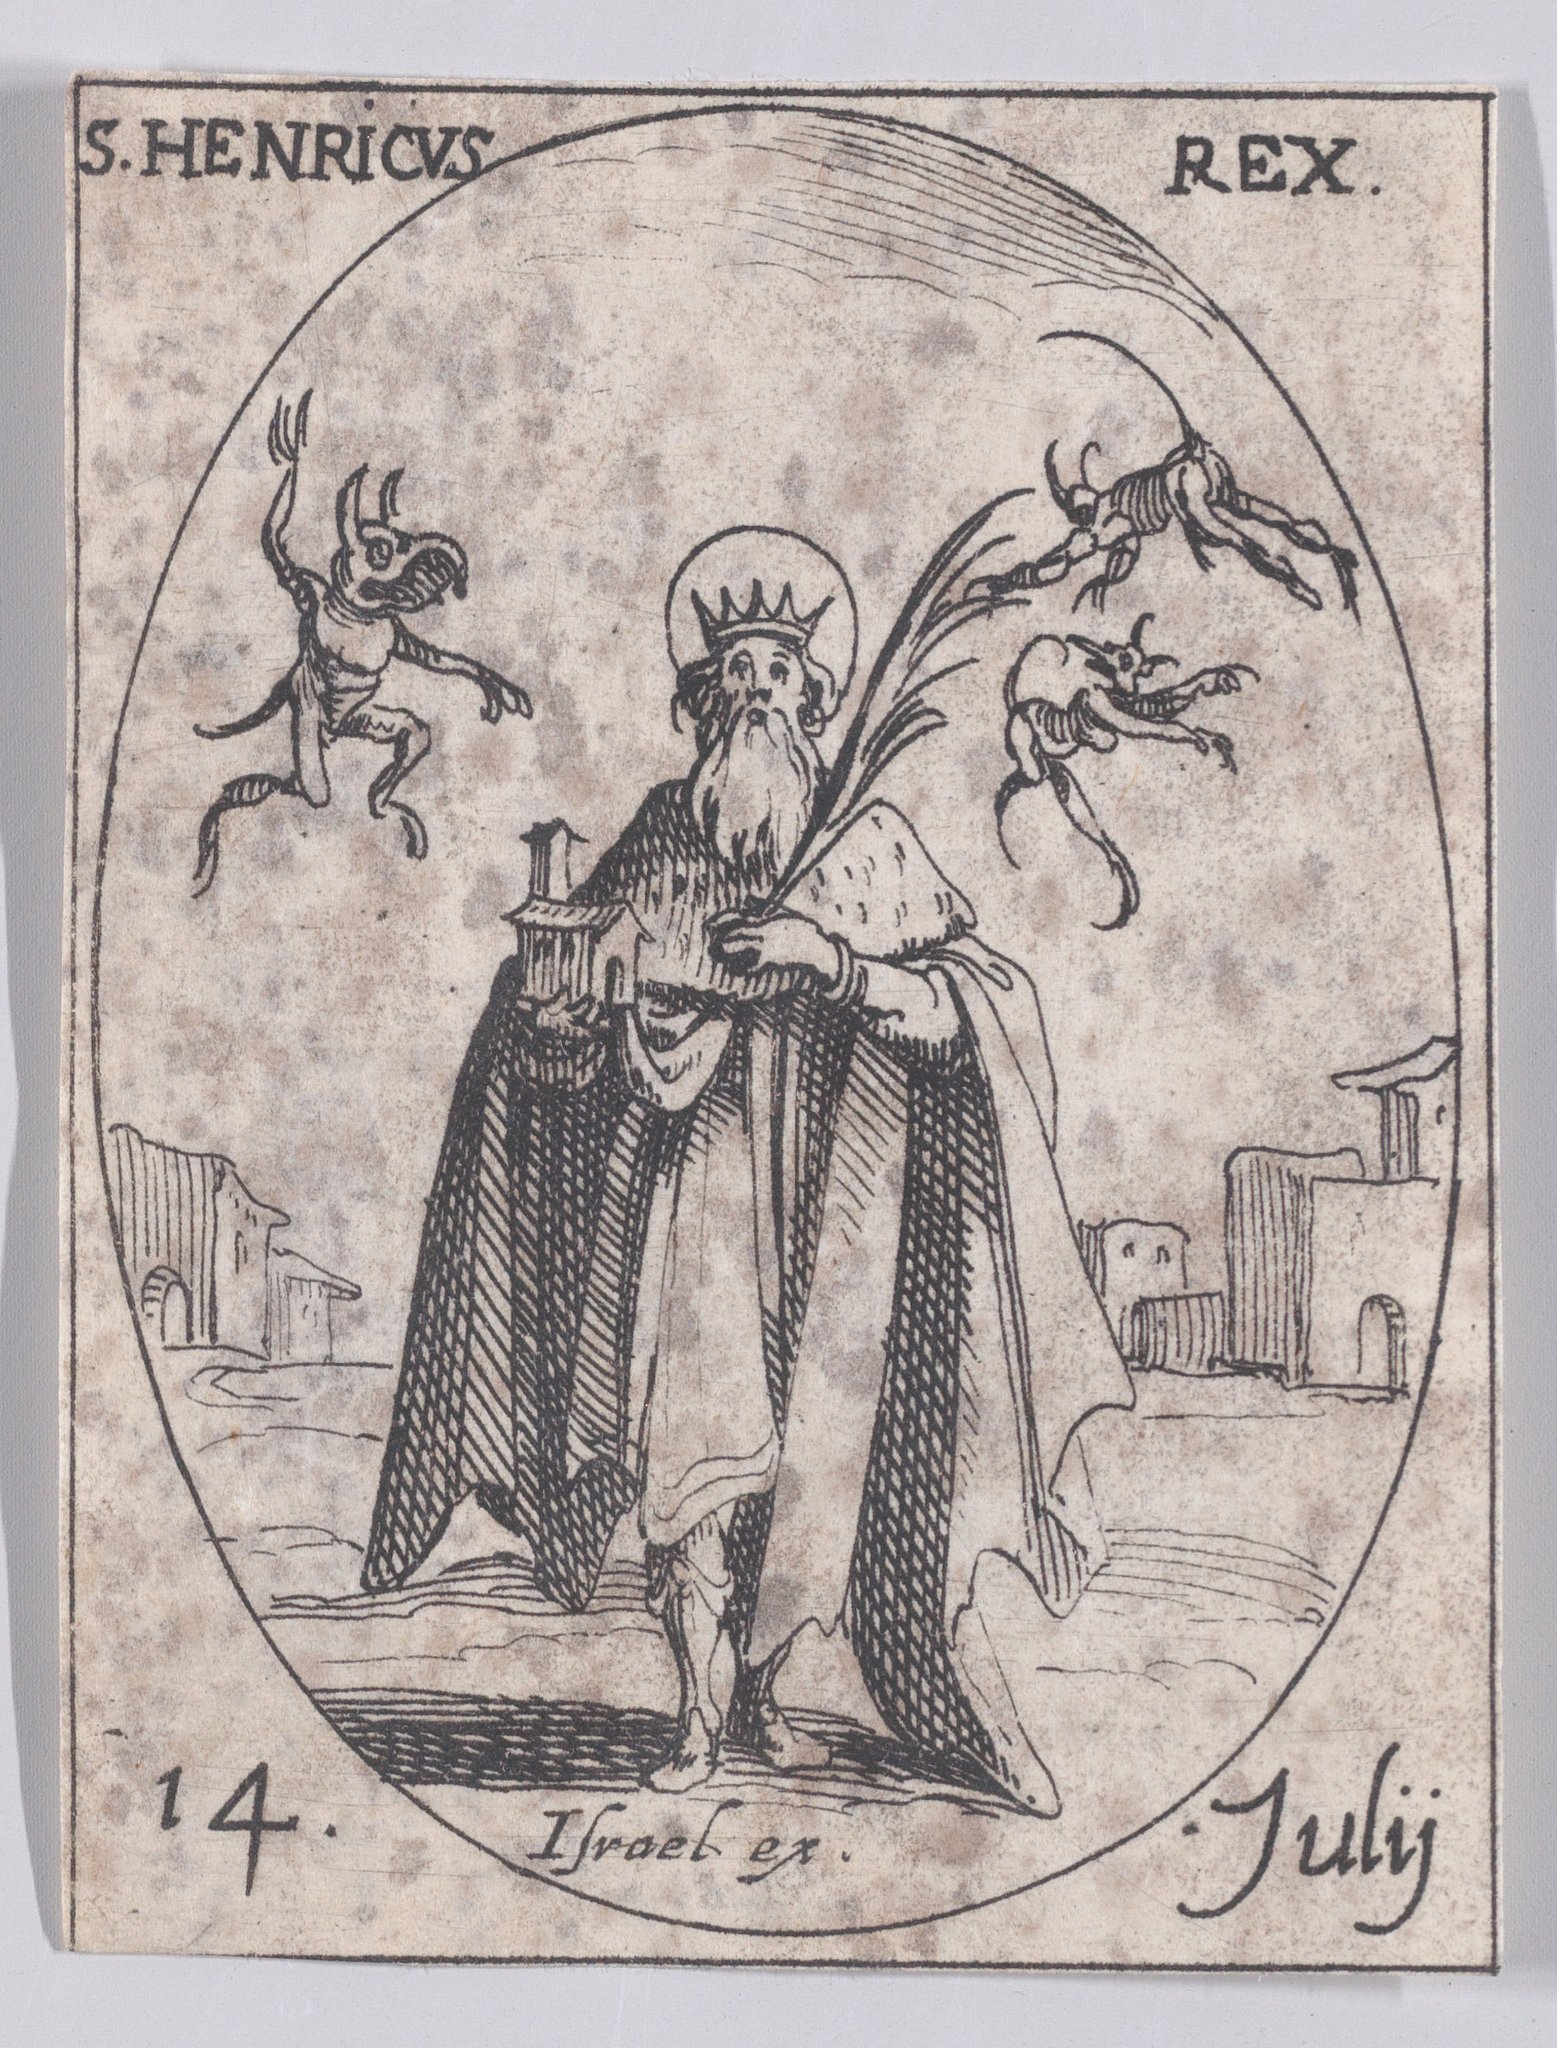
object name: print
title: S. Henri, roi (St. Henry, King), July 14th, from "Les Images De Tous Les Saincts et Saintes de L'Année" (Images of All of the Saints and Feast Days of the Year)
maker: jacques callot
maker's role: artist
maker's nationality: french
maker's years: 1592-1635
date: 1636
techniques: etching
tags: men,demons,saints